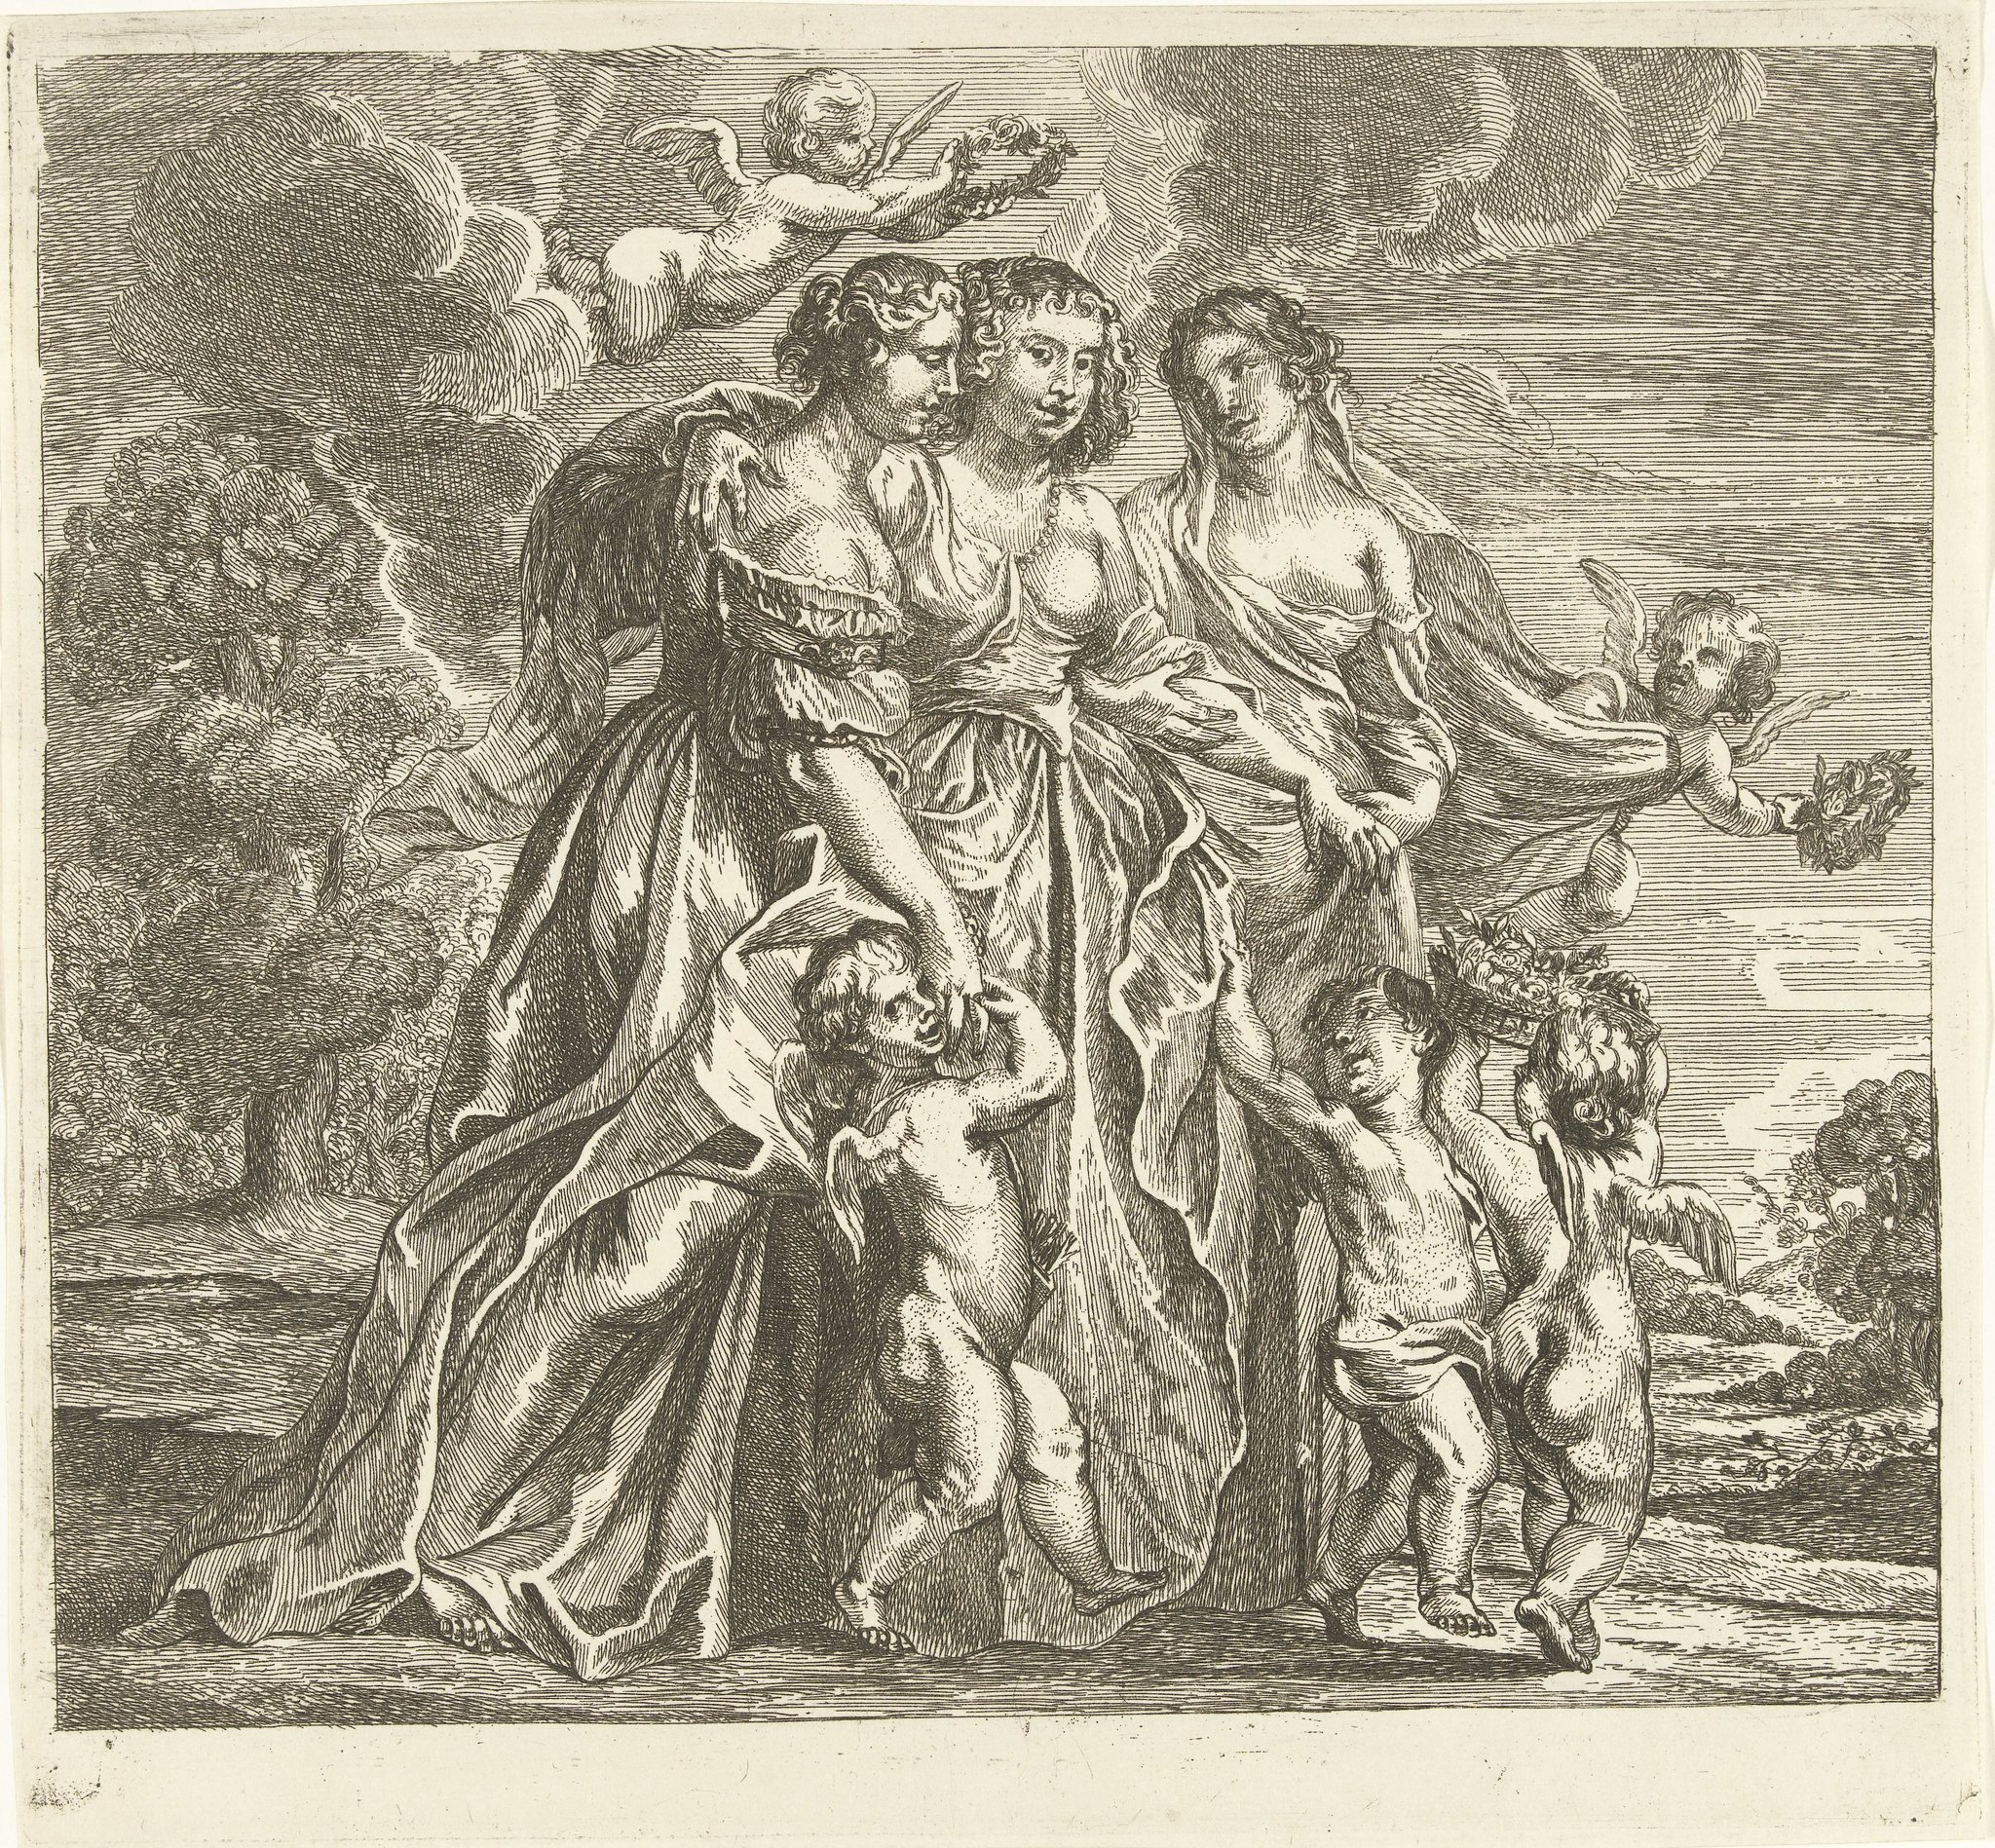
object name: print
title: Drie gratiën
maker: remoldus eynhoudts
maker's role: print maker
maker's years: 1613-1680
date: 1626-1680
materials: paper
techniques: etching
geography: antwerp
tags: graces (charites), generally three in number; 'gratie' (ripa)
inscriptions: collector's mark: Lugt 2228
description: De drie gratiën vergezeld van vijf putti waarvan één met een bloemenmand en twee met bloemenkransen.